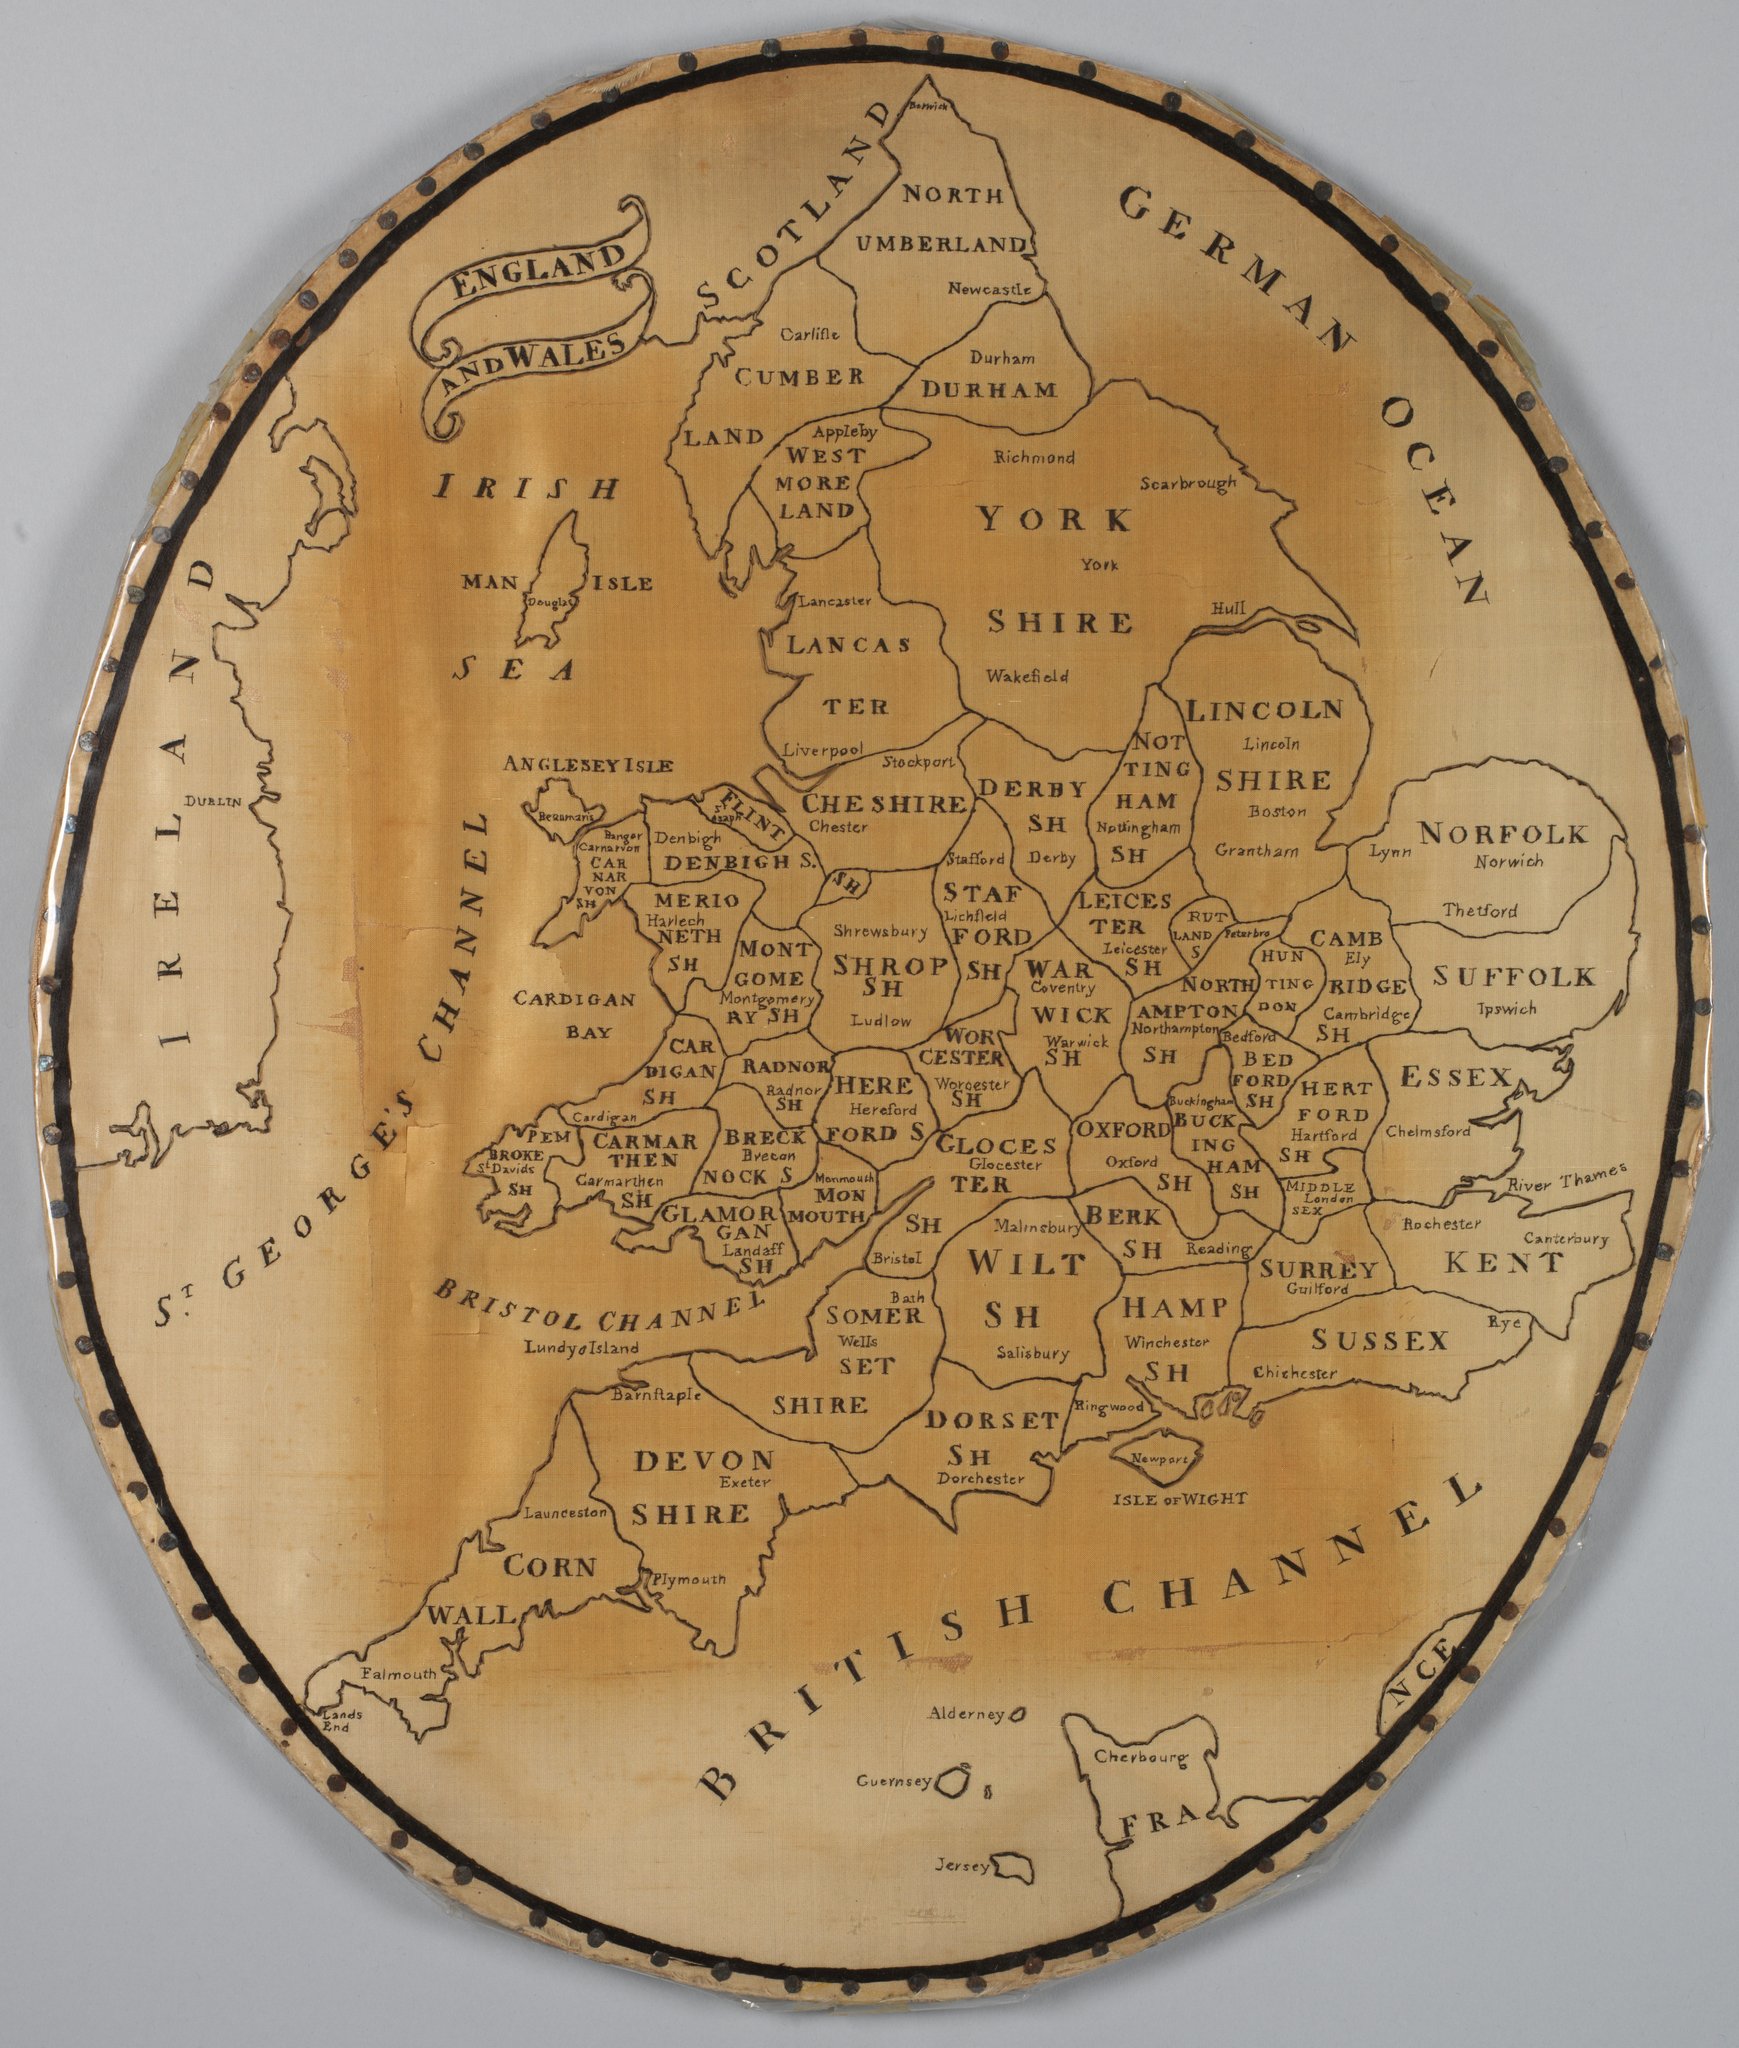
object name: sampler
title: Embroidered map sampler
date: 1767-1833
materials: silk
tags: maps